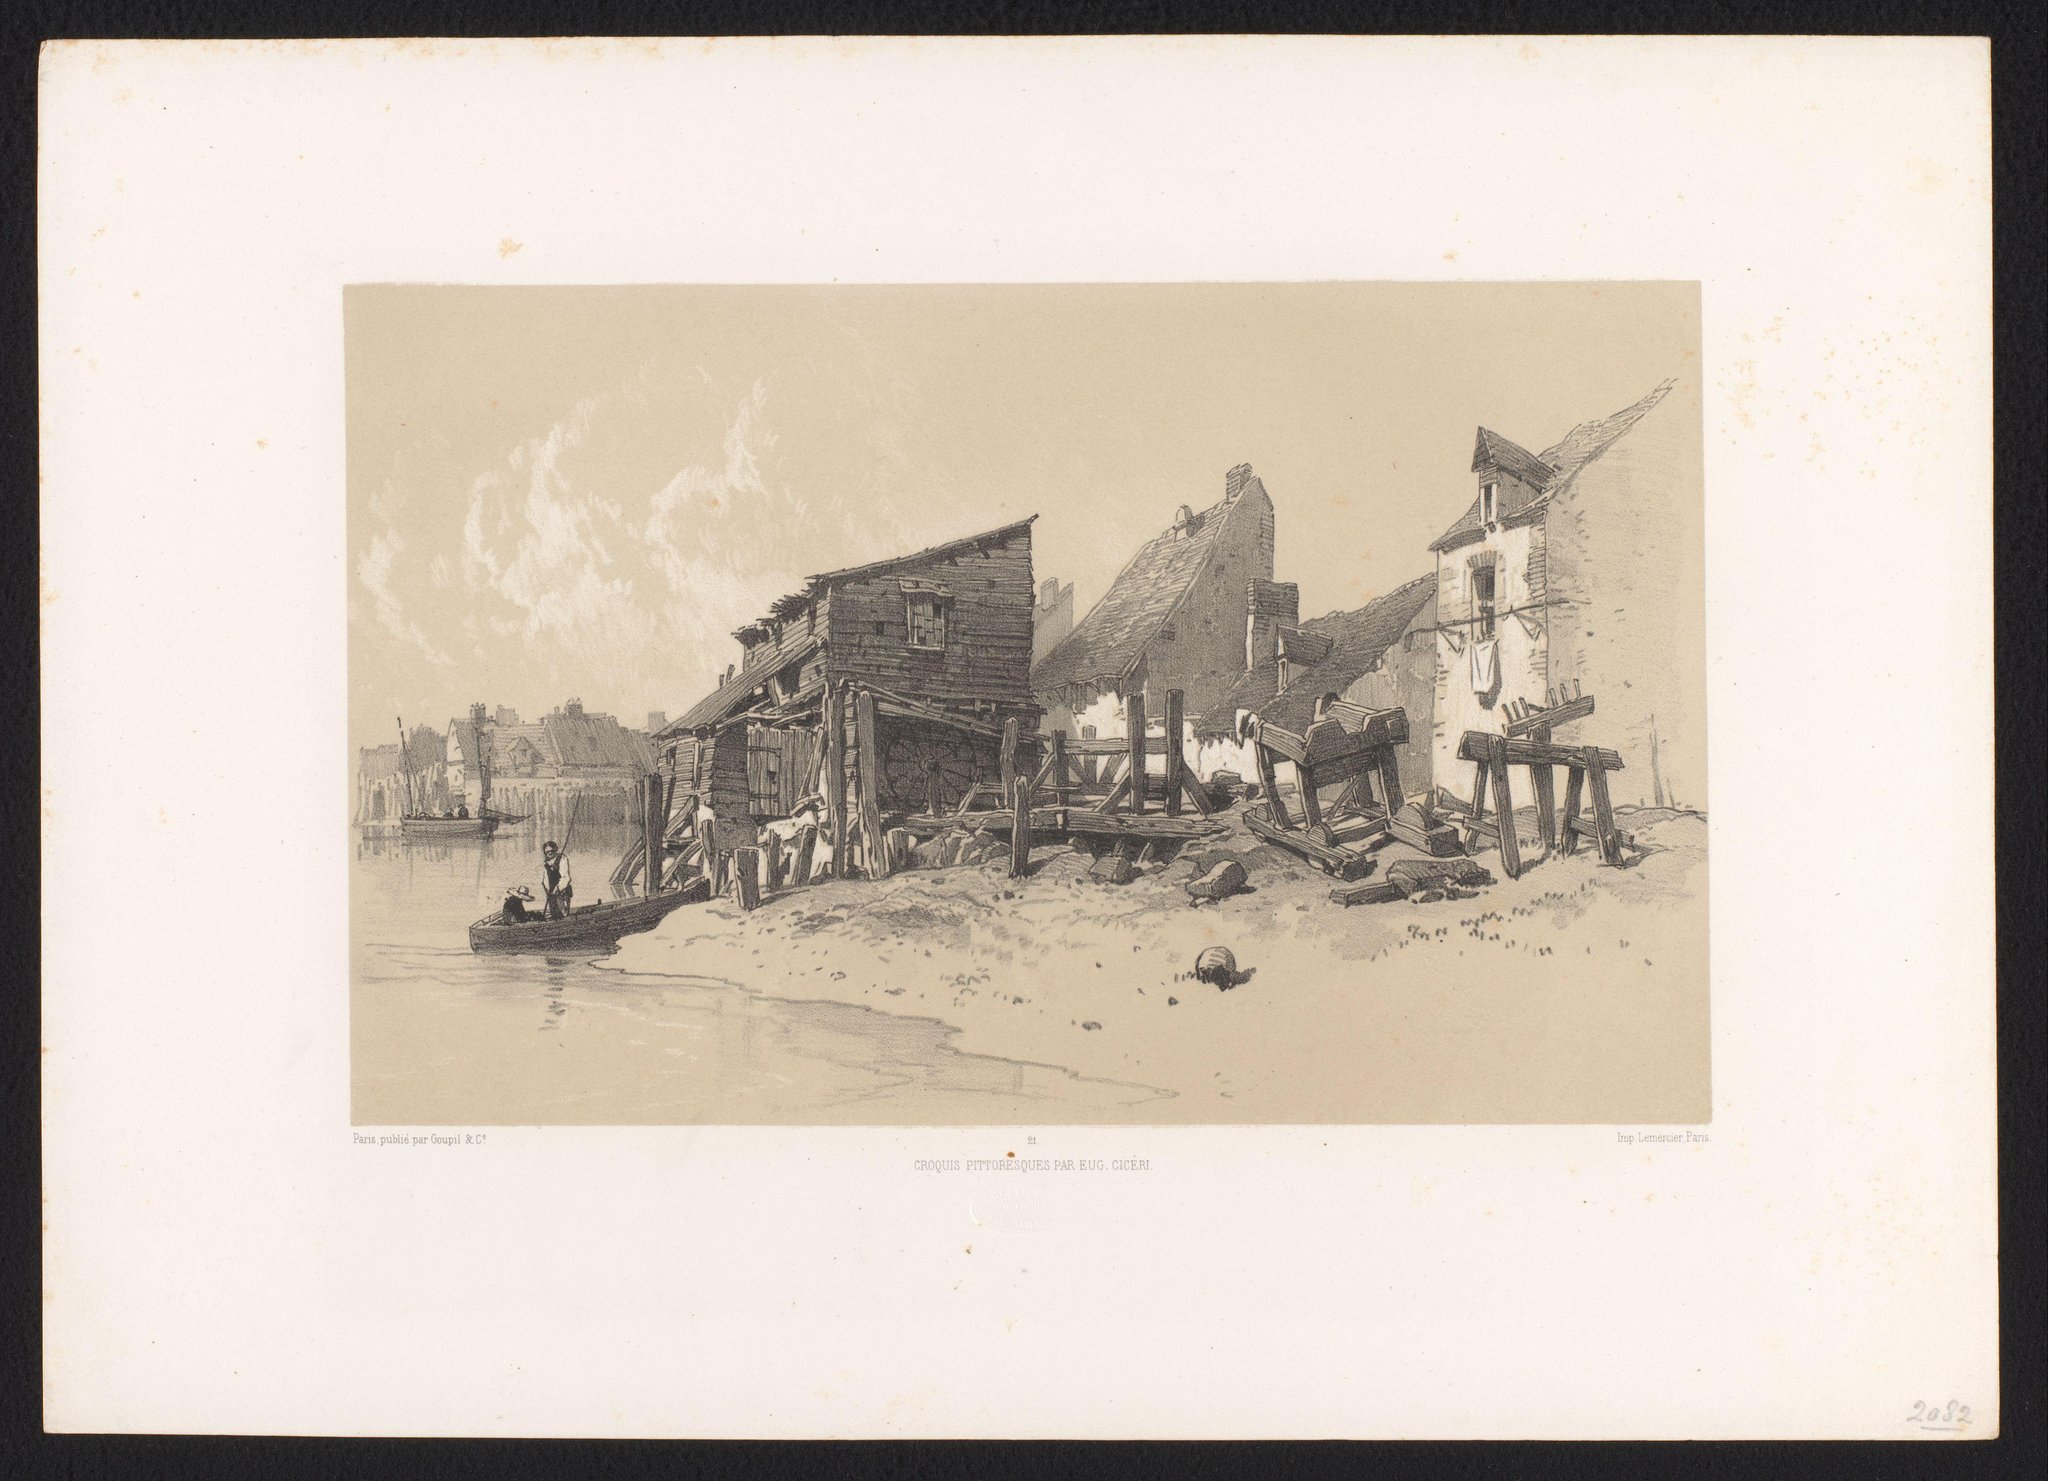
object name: print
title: Pittoreske landschappen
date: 1854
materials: paper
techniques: tone lithography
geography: paris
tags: rowing-boat, canoe, etc., watermill, river (+ landscape with figures, staffage), civic architecture; edifices; dwellings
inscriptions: check stamp: Lugt 1090, number: ‘2082’